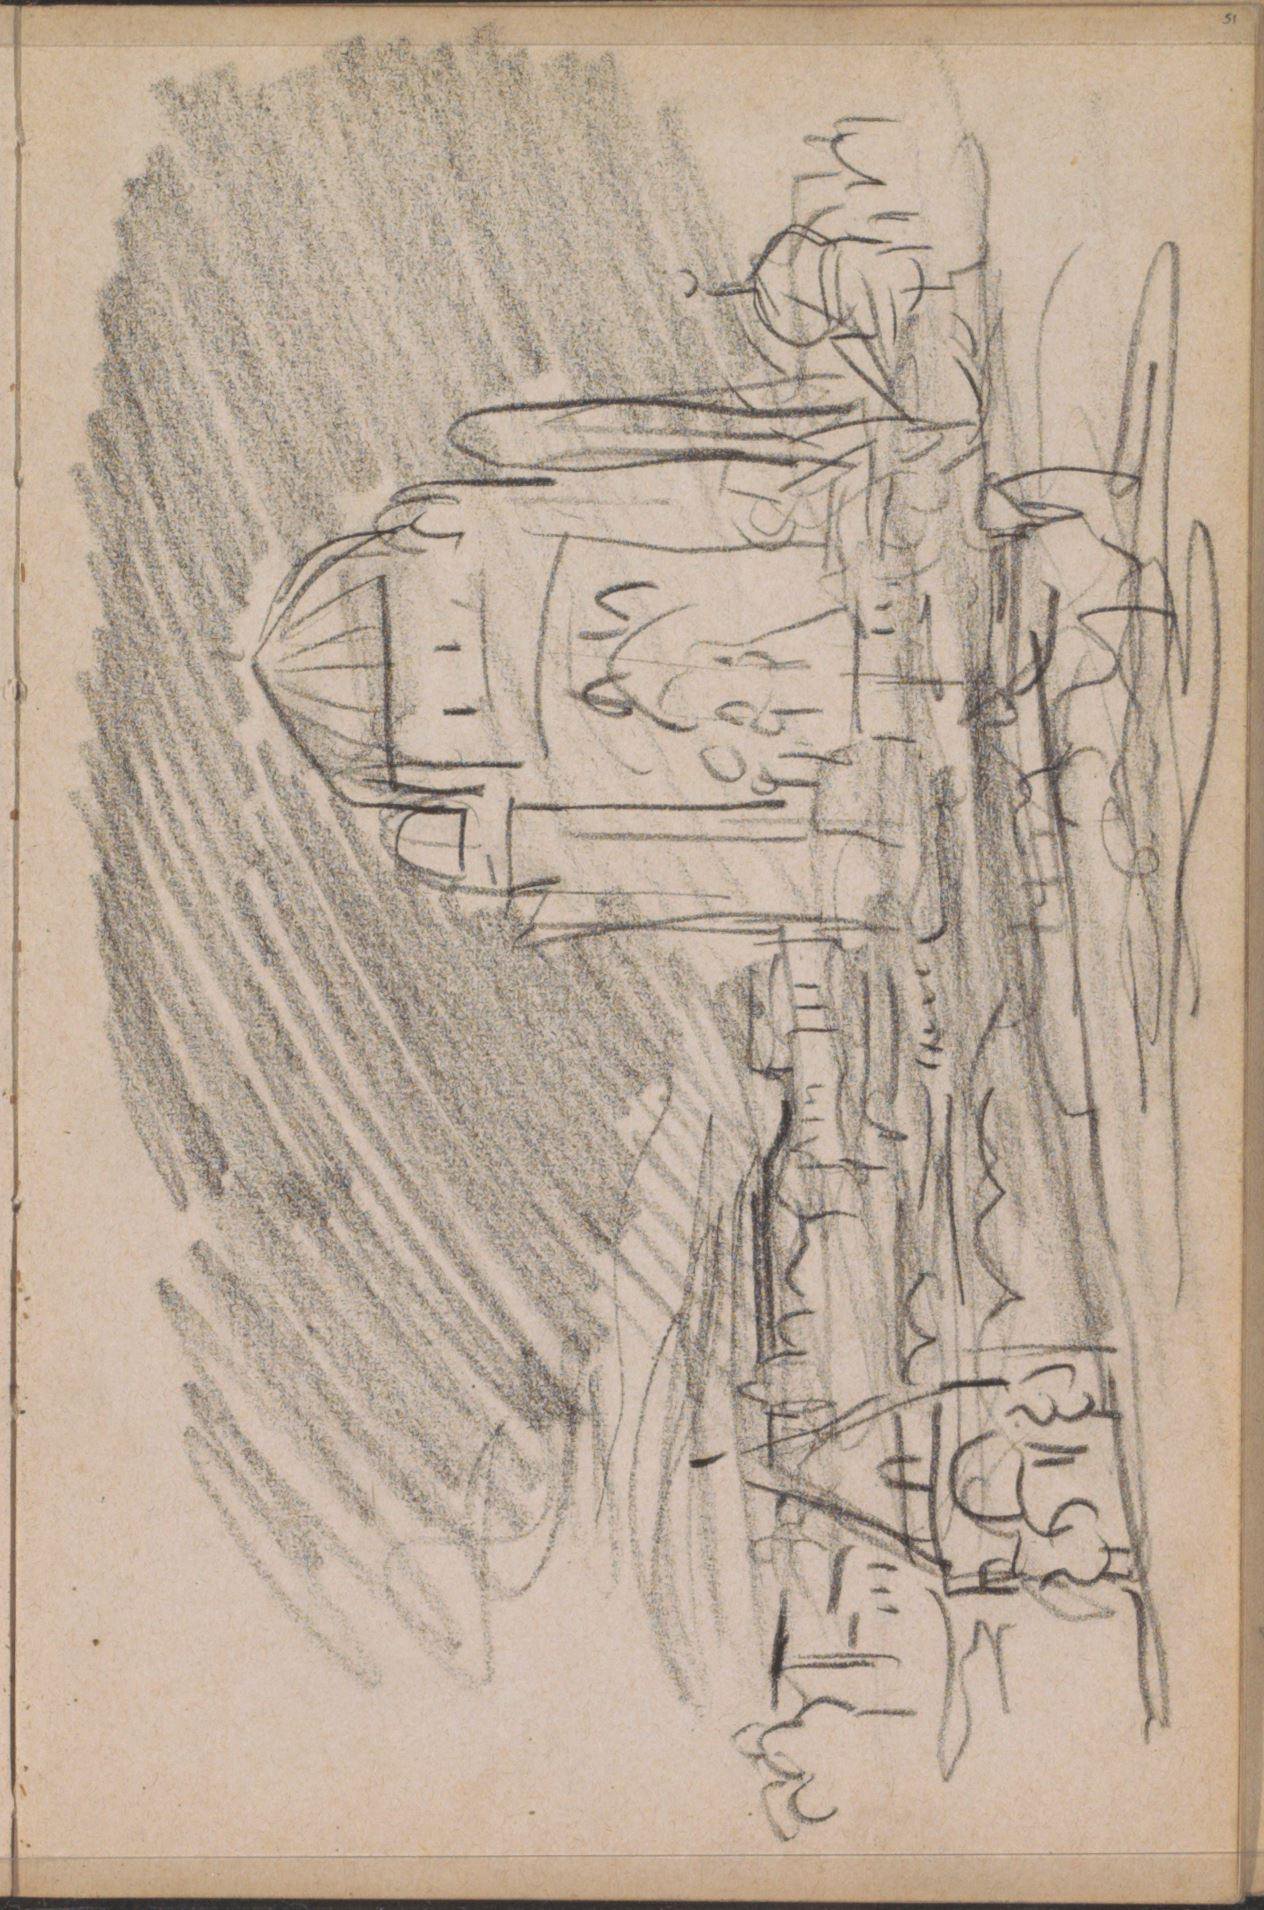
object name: sketchbook leaf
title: Stadsgezicht met een kathedraal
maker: marius bauer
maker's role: draughtsman, print maker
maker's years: 1867-1932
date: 1896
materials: chalk, paper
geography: moscow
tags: city-view, and landscape with man-made constructions, spire (of tower on house or building), parts of church exterior and annexes: spire, dome ~ architecture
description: De kathedraal heeft een koepeldak. Op de voorgrond zijn ook verschillende torenspitsen te zien. Pagina 51 uit een schetsboek met 45 bladen.